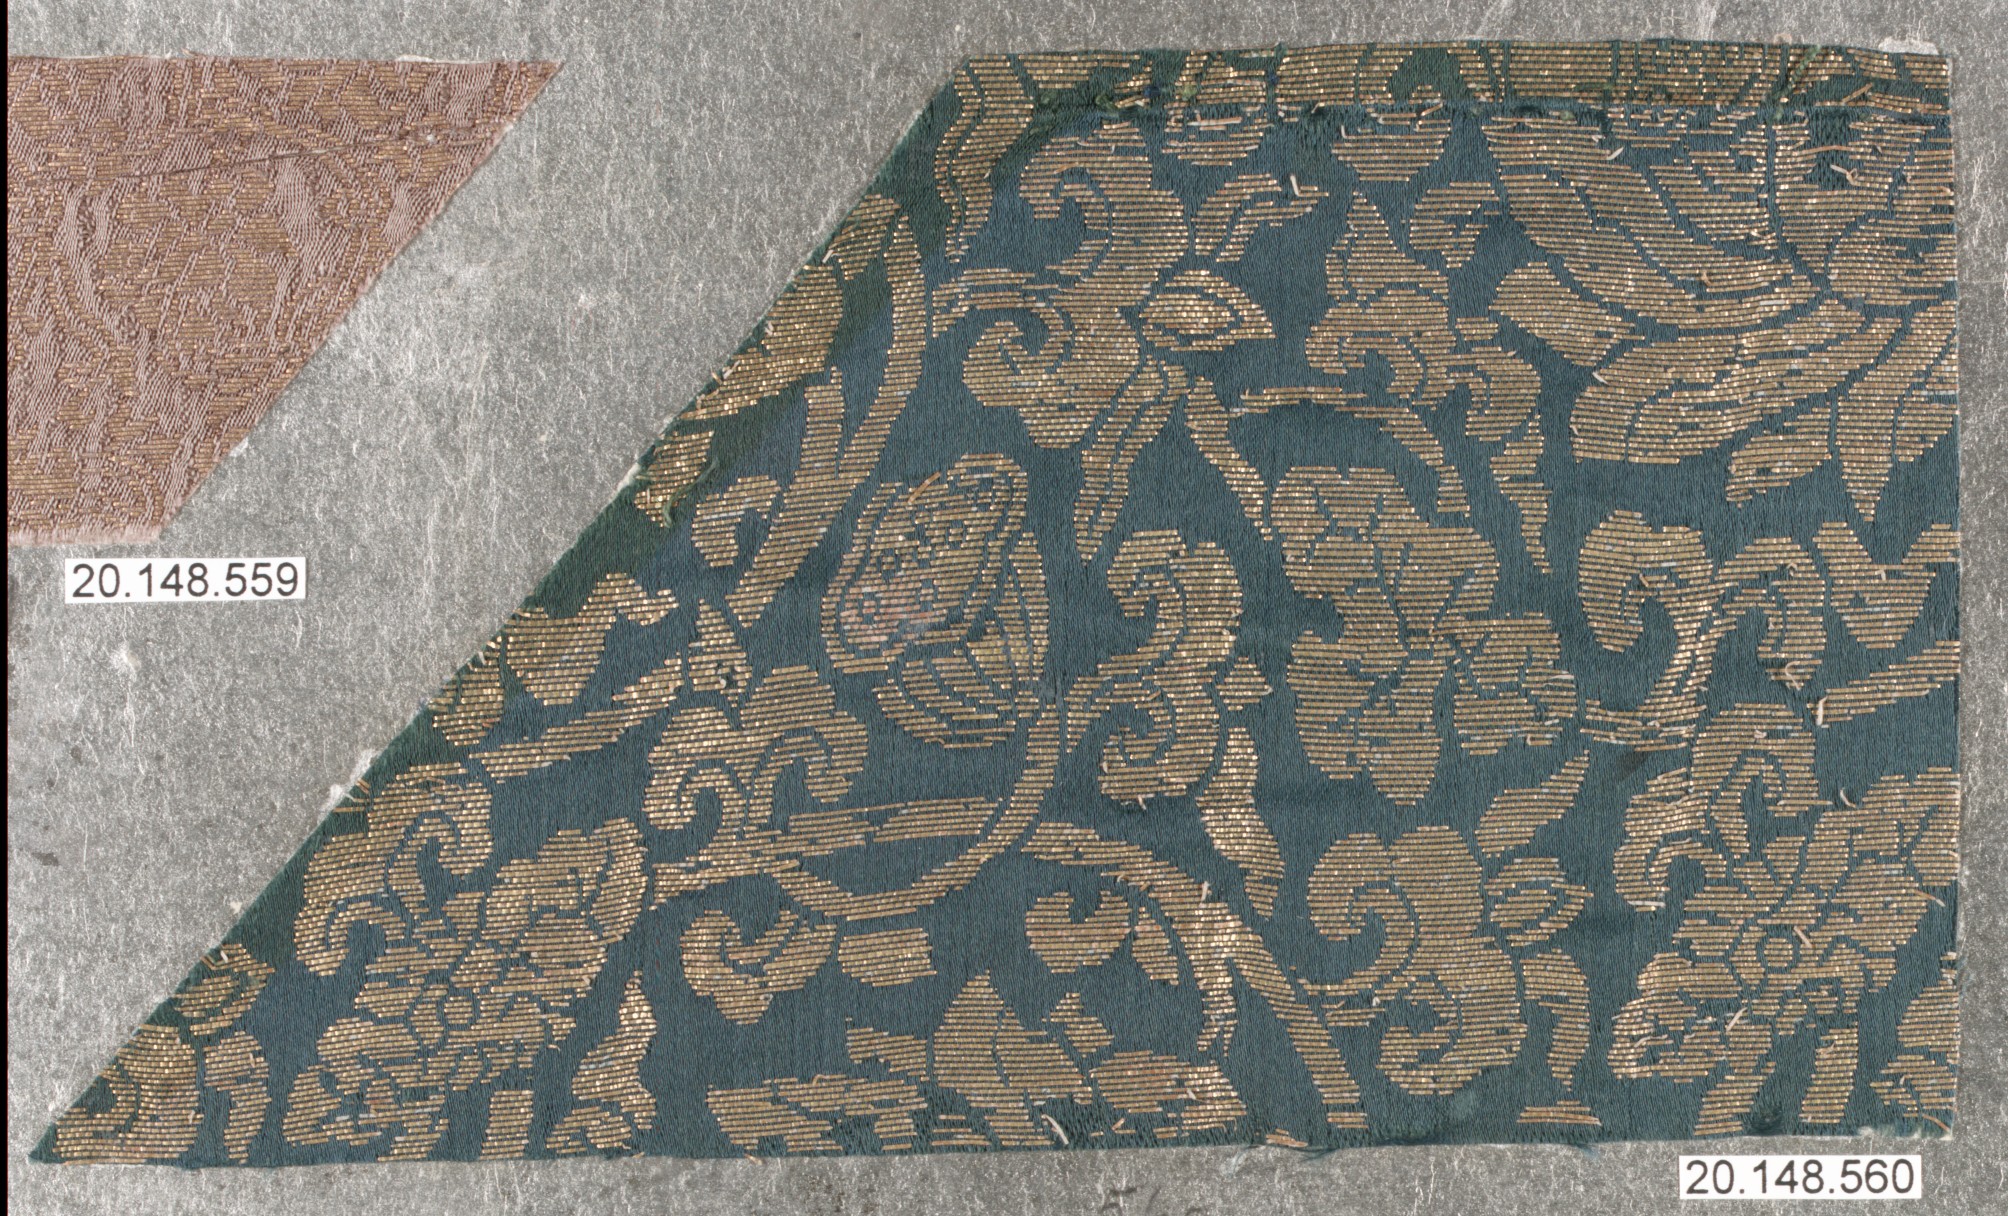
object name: piece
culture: japanese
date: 1701-1800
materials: silk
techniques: compound weave